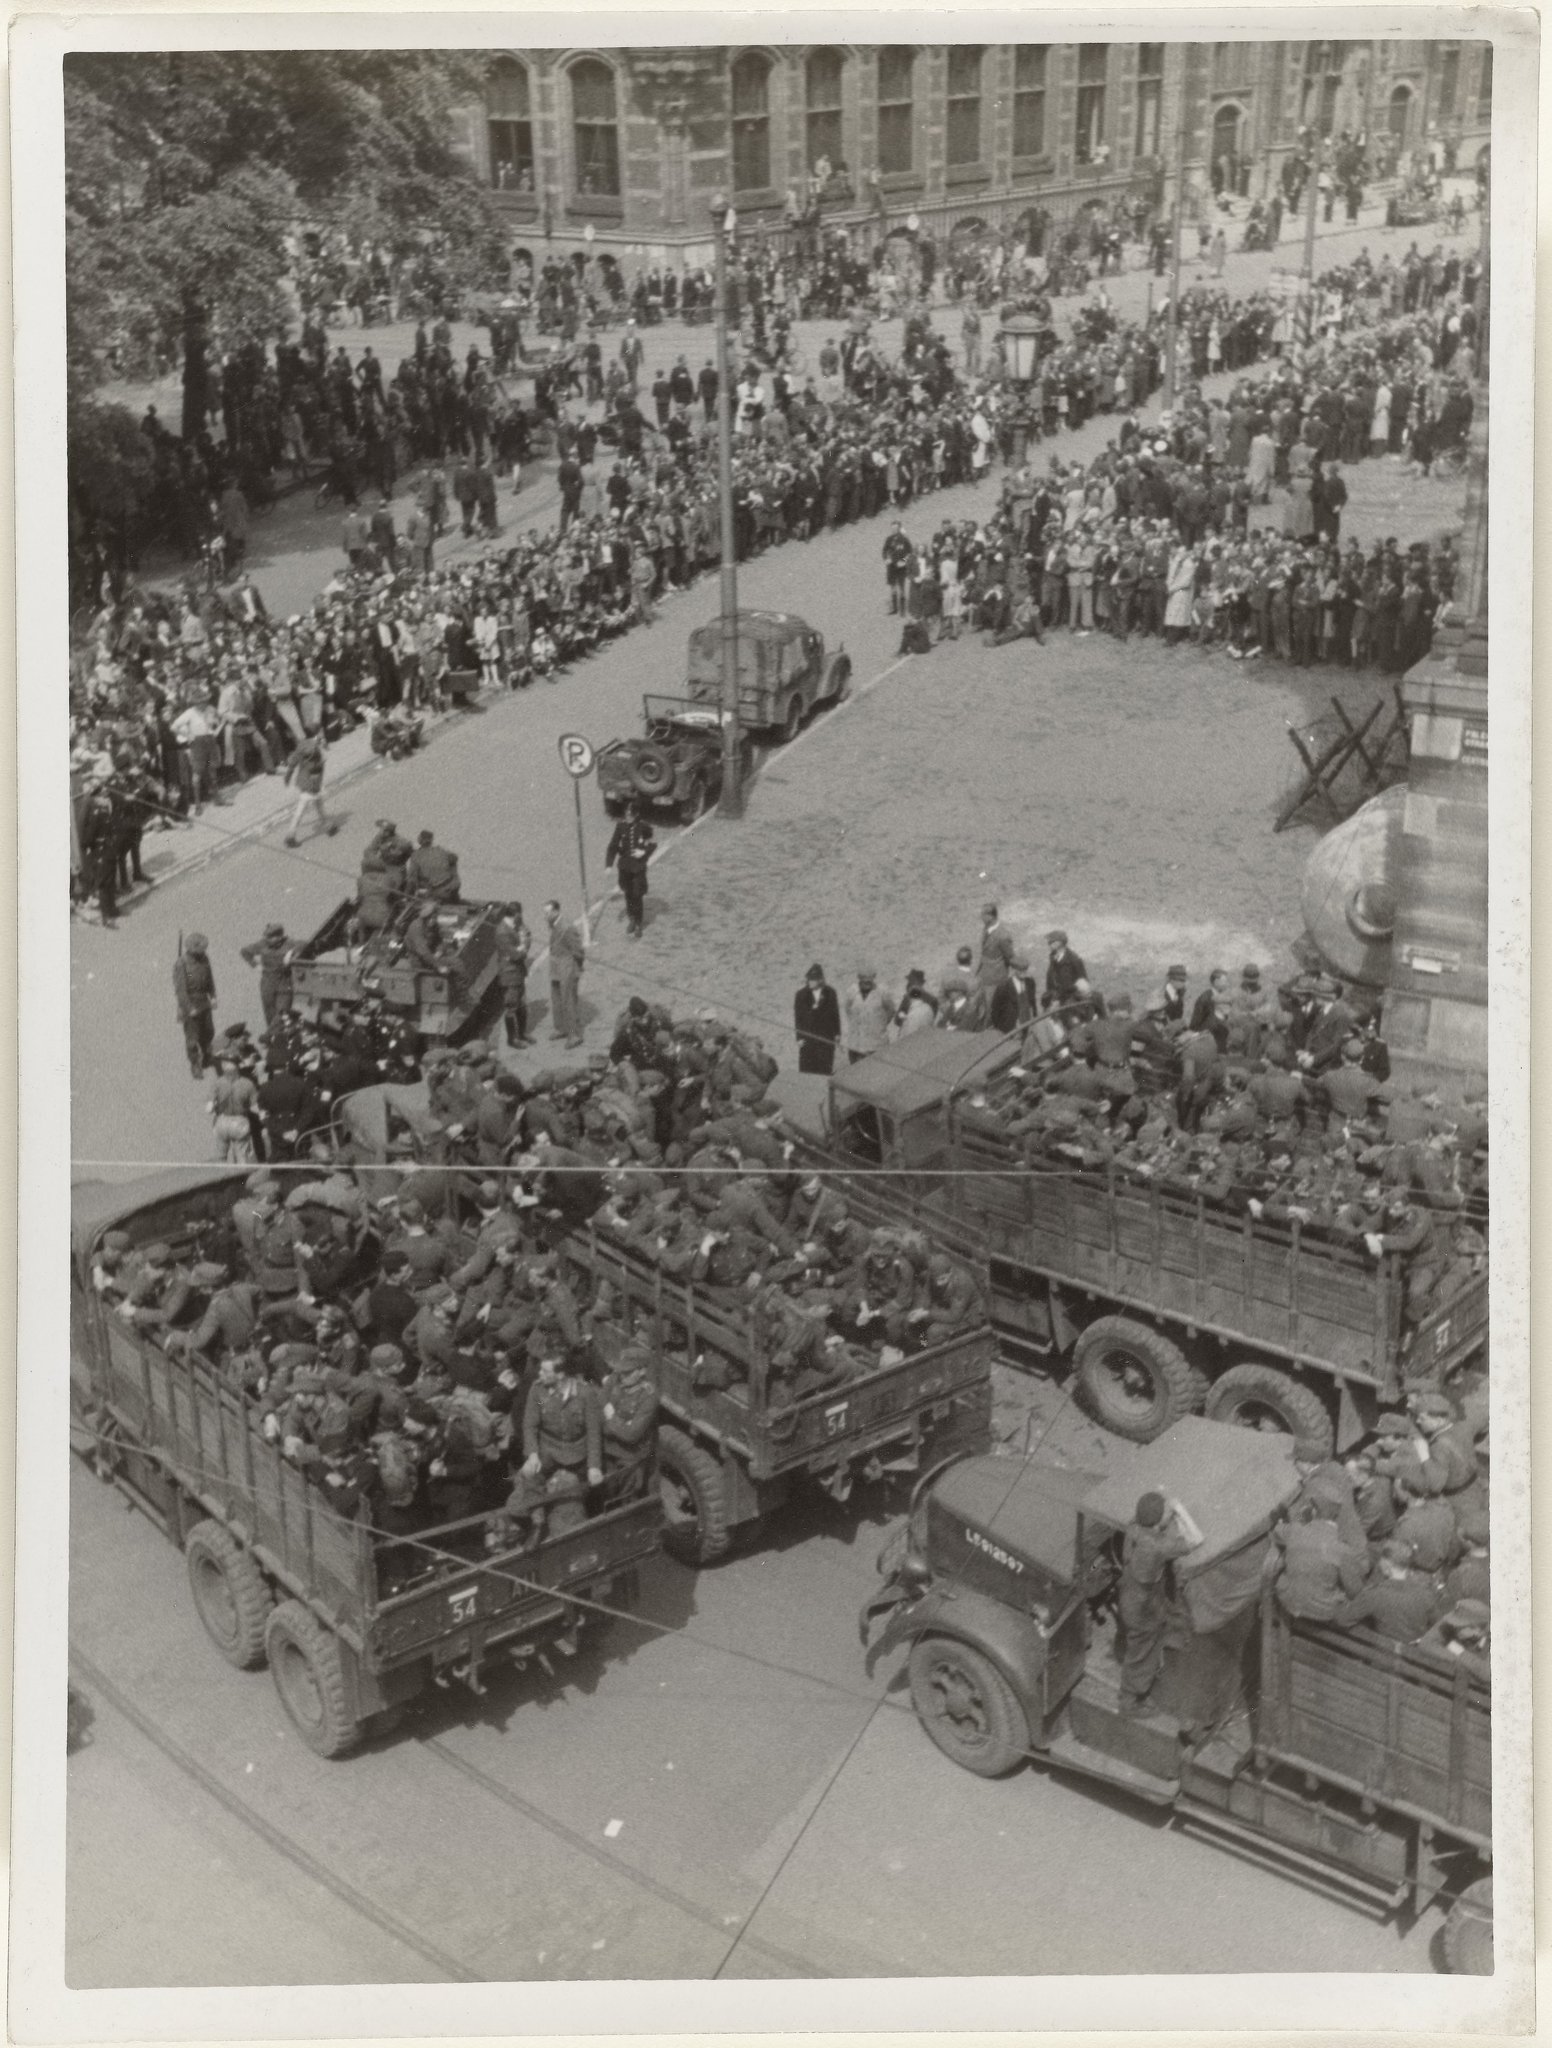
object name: photograph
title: Ontruiming Groote Club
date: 1945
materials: photographic support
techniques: photography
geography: amsterdam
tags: amsterdam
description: Legervoertuigen rijden de Nieuwe Zijds Voorburgwal op tijdens de ontruiming van de Groote Club, (hoek Kalverstraat / Dam) van waaruit op 7 mei door de Kriegsmarine was geschoten op de menigte op de Dam. Veel Amsterdammers staan toe te kijken hoe de gevangen Duitsers worden afgevoerd. Vermoedelijk gebeurde dit een dag na de schietpartij, dus op 8 mei.